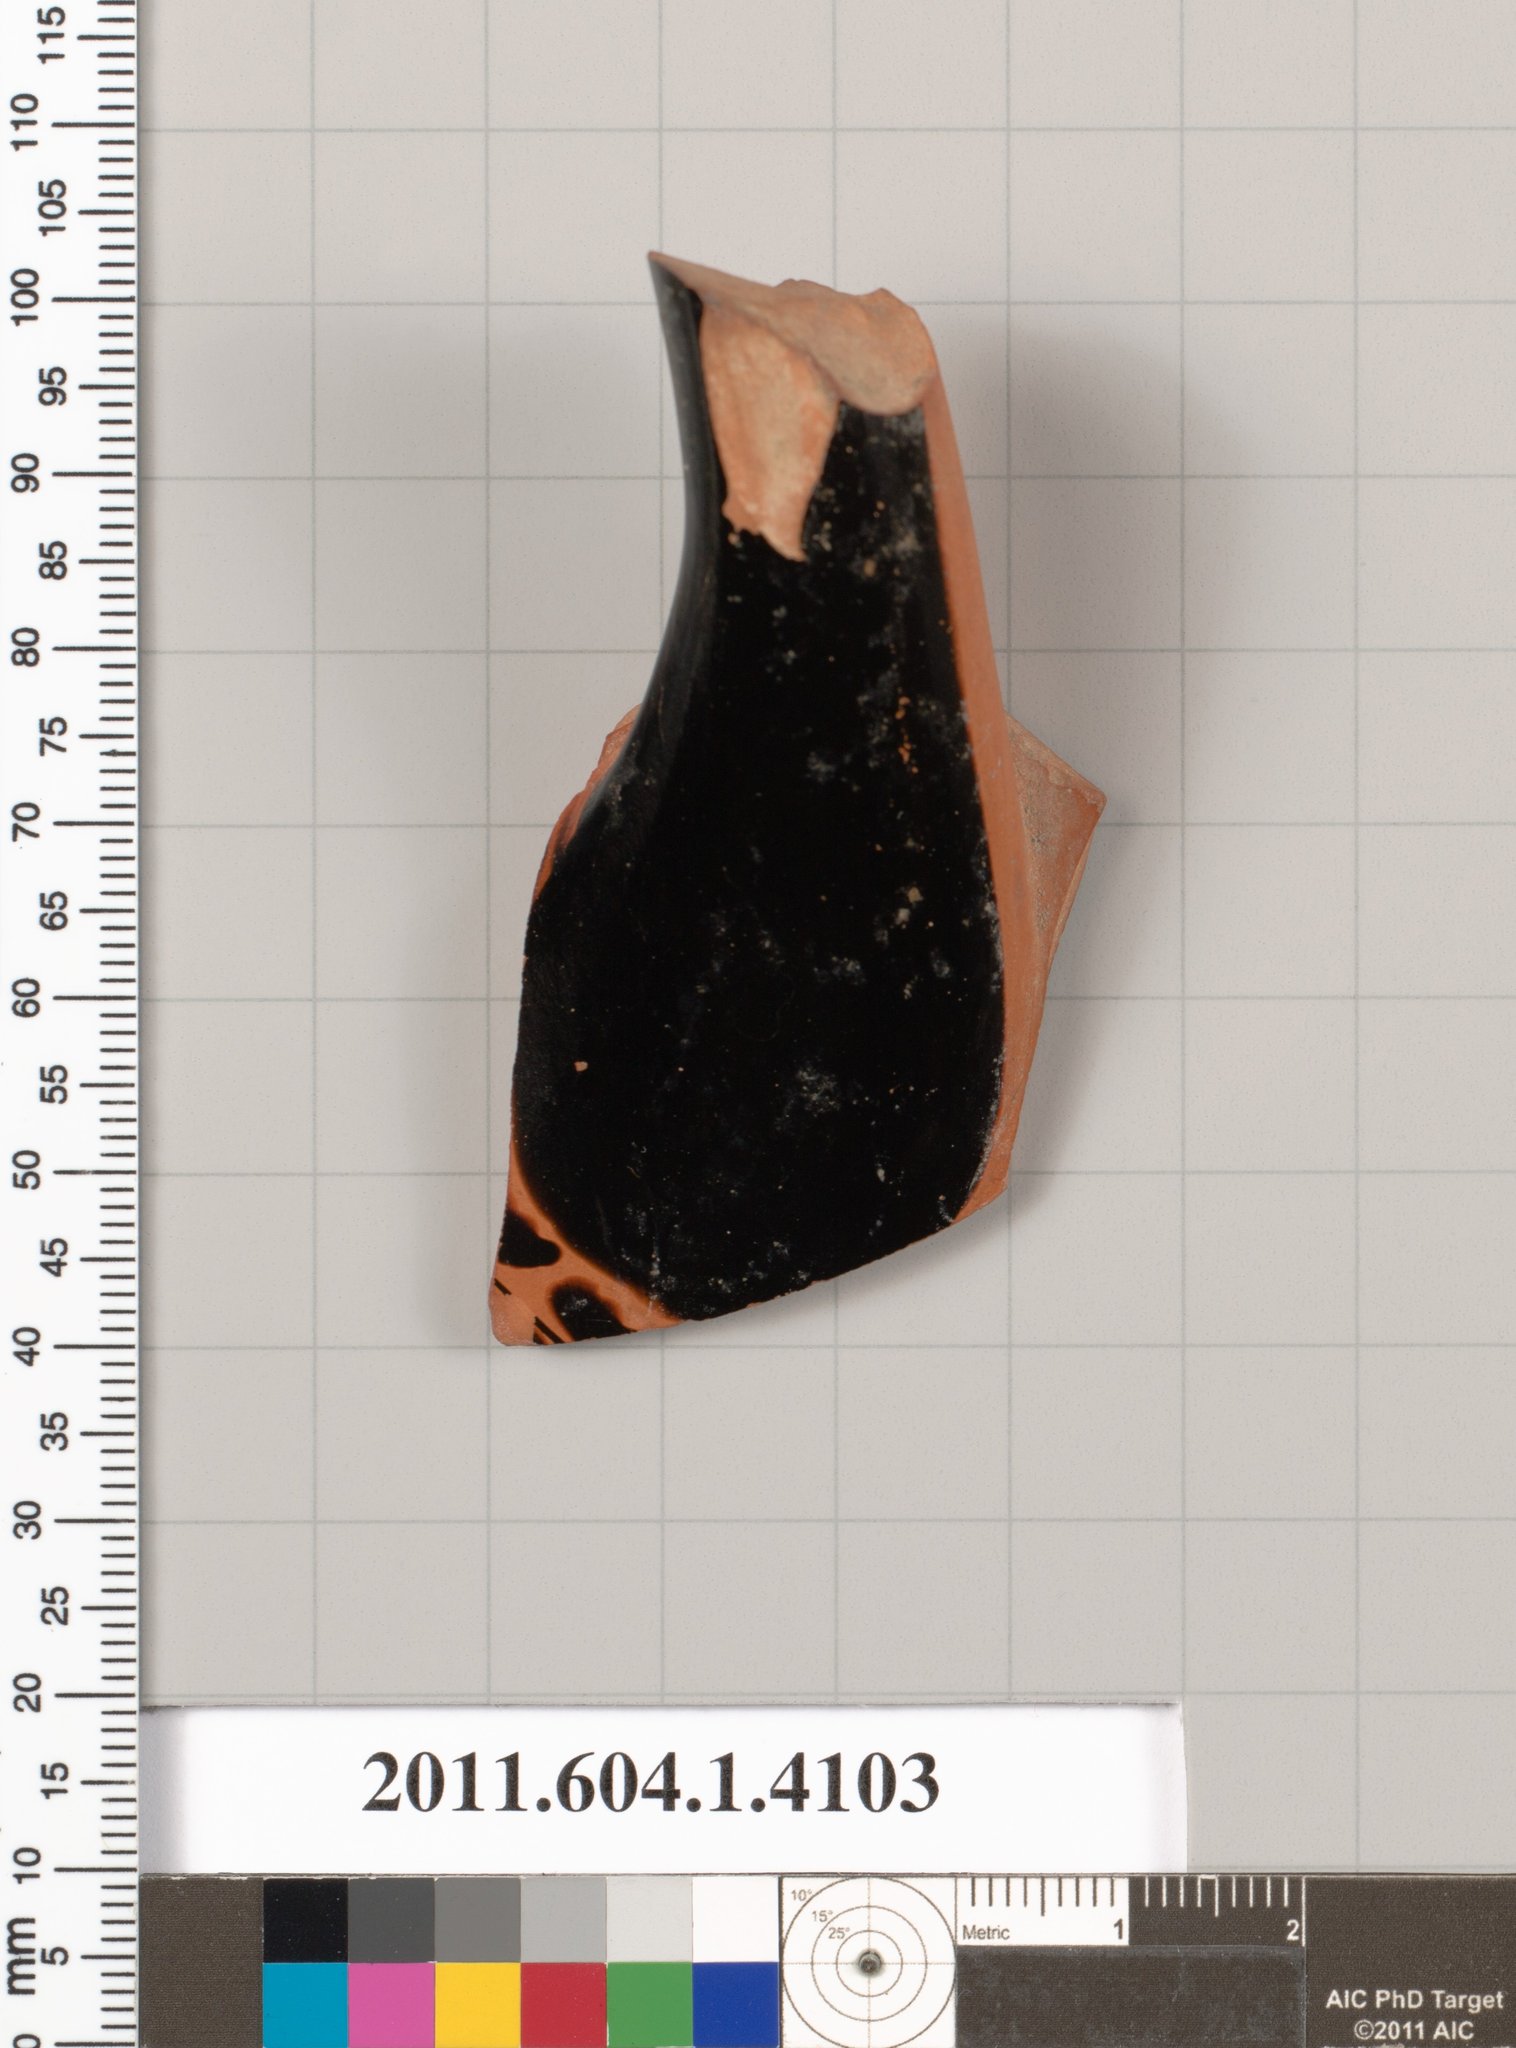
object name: kylix fragment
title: Terracotta fragment of a kylix (drinking cup)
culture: greek, attic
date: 520-500 BCE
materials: terracotta